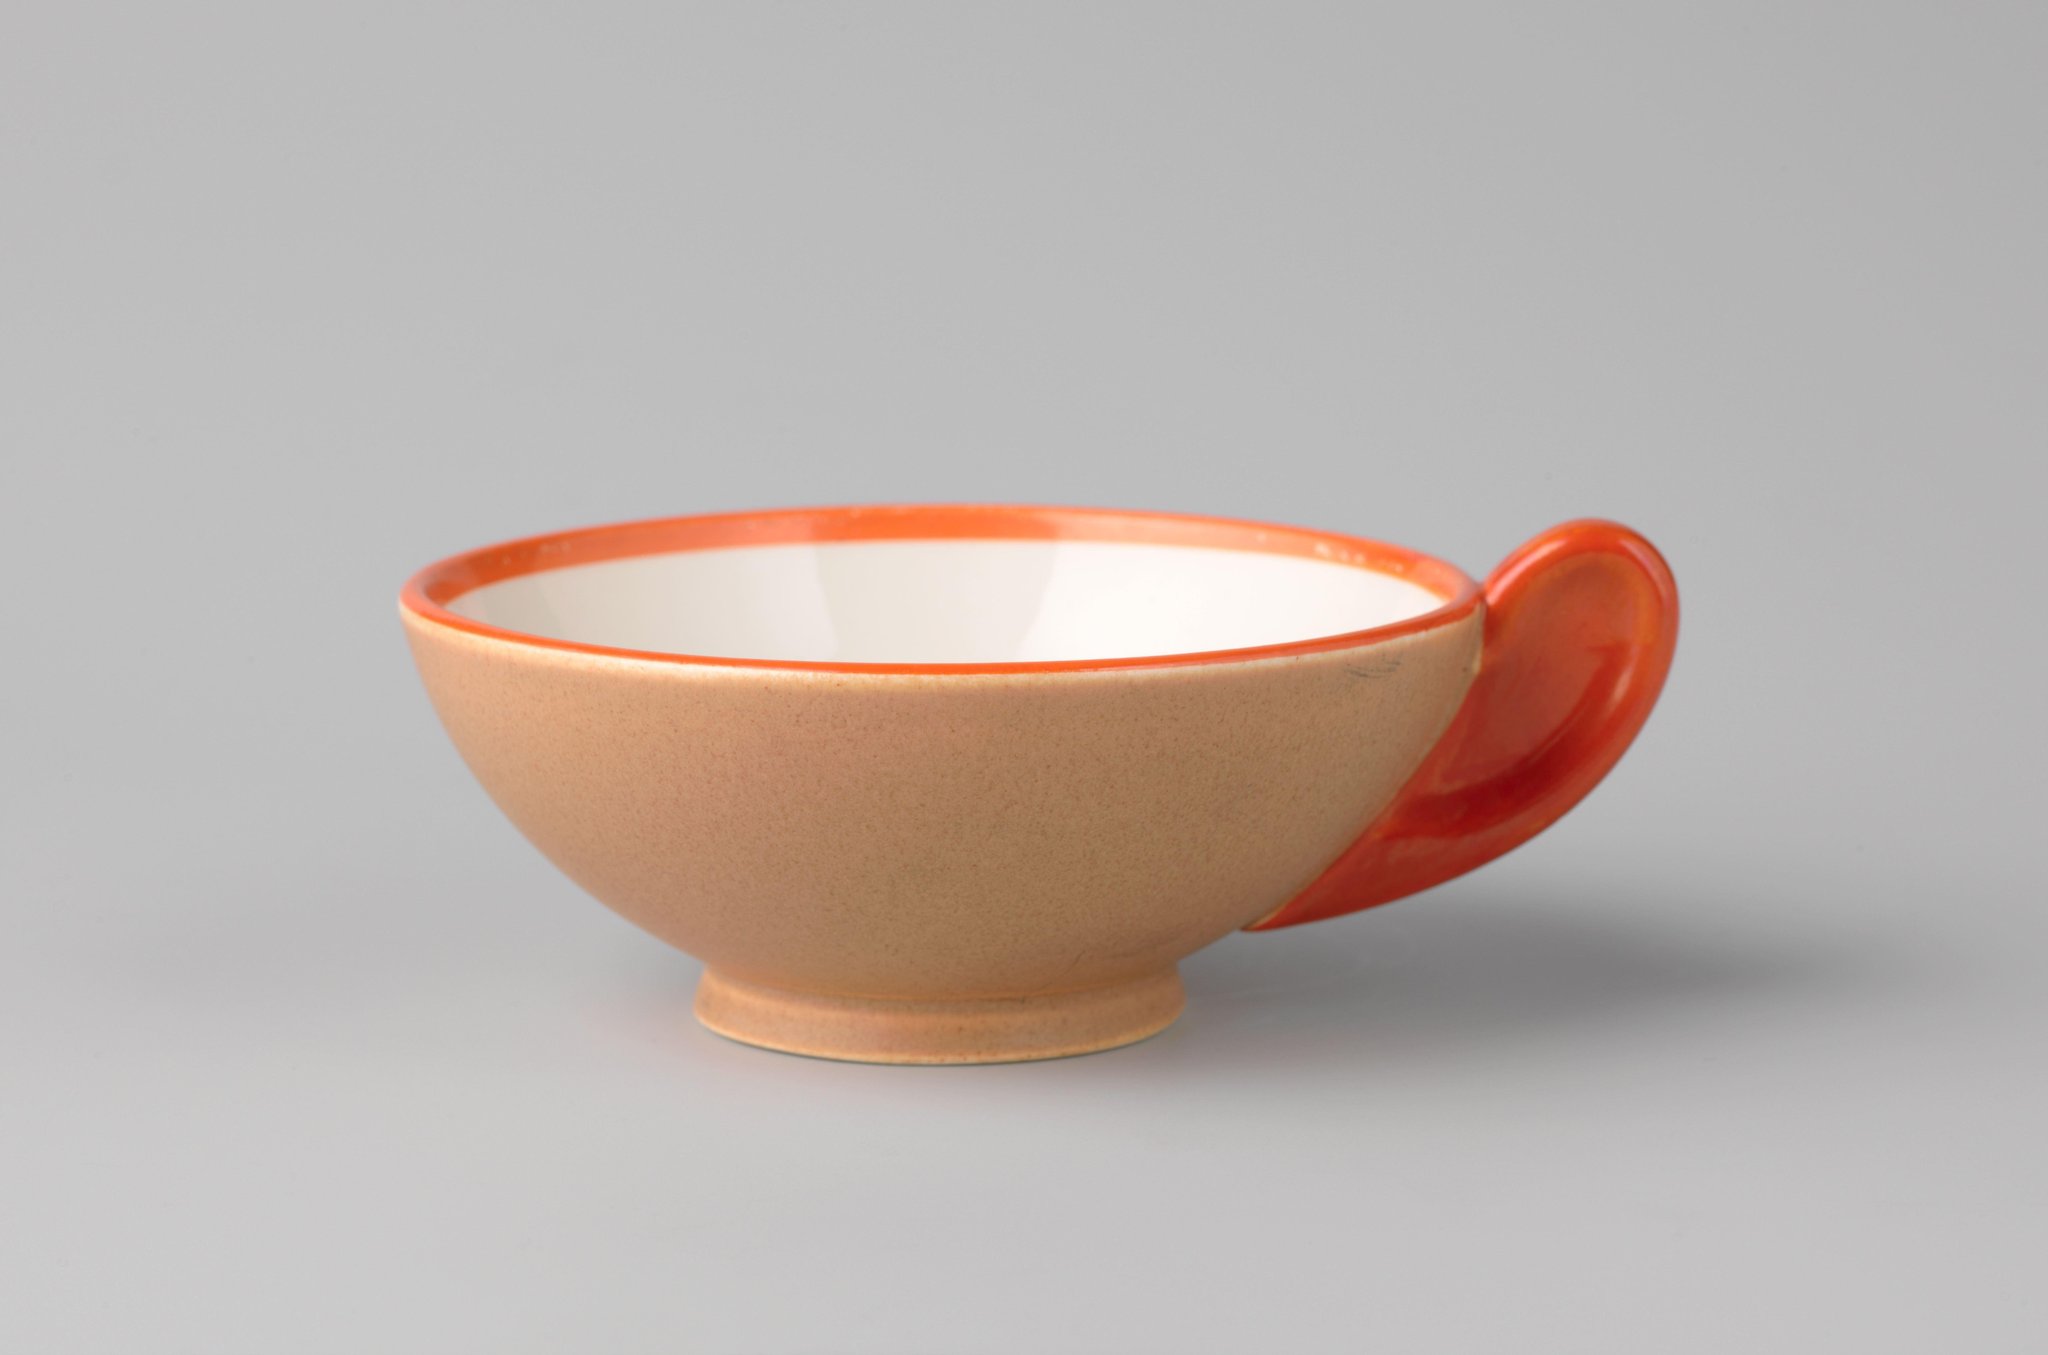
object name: tea cup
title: Theekop, deel van een theeservies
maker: edmond bellefroid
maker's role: ceramicist, painter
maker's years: 1893-1971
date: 1934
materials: earthenware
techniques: painted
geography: maastricht